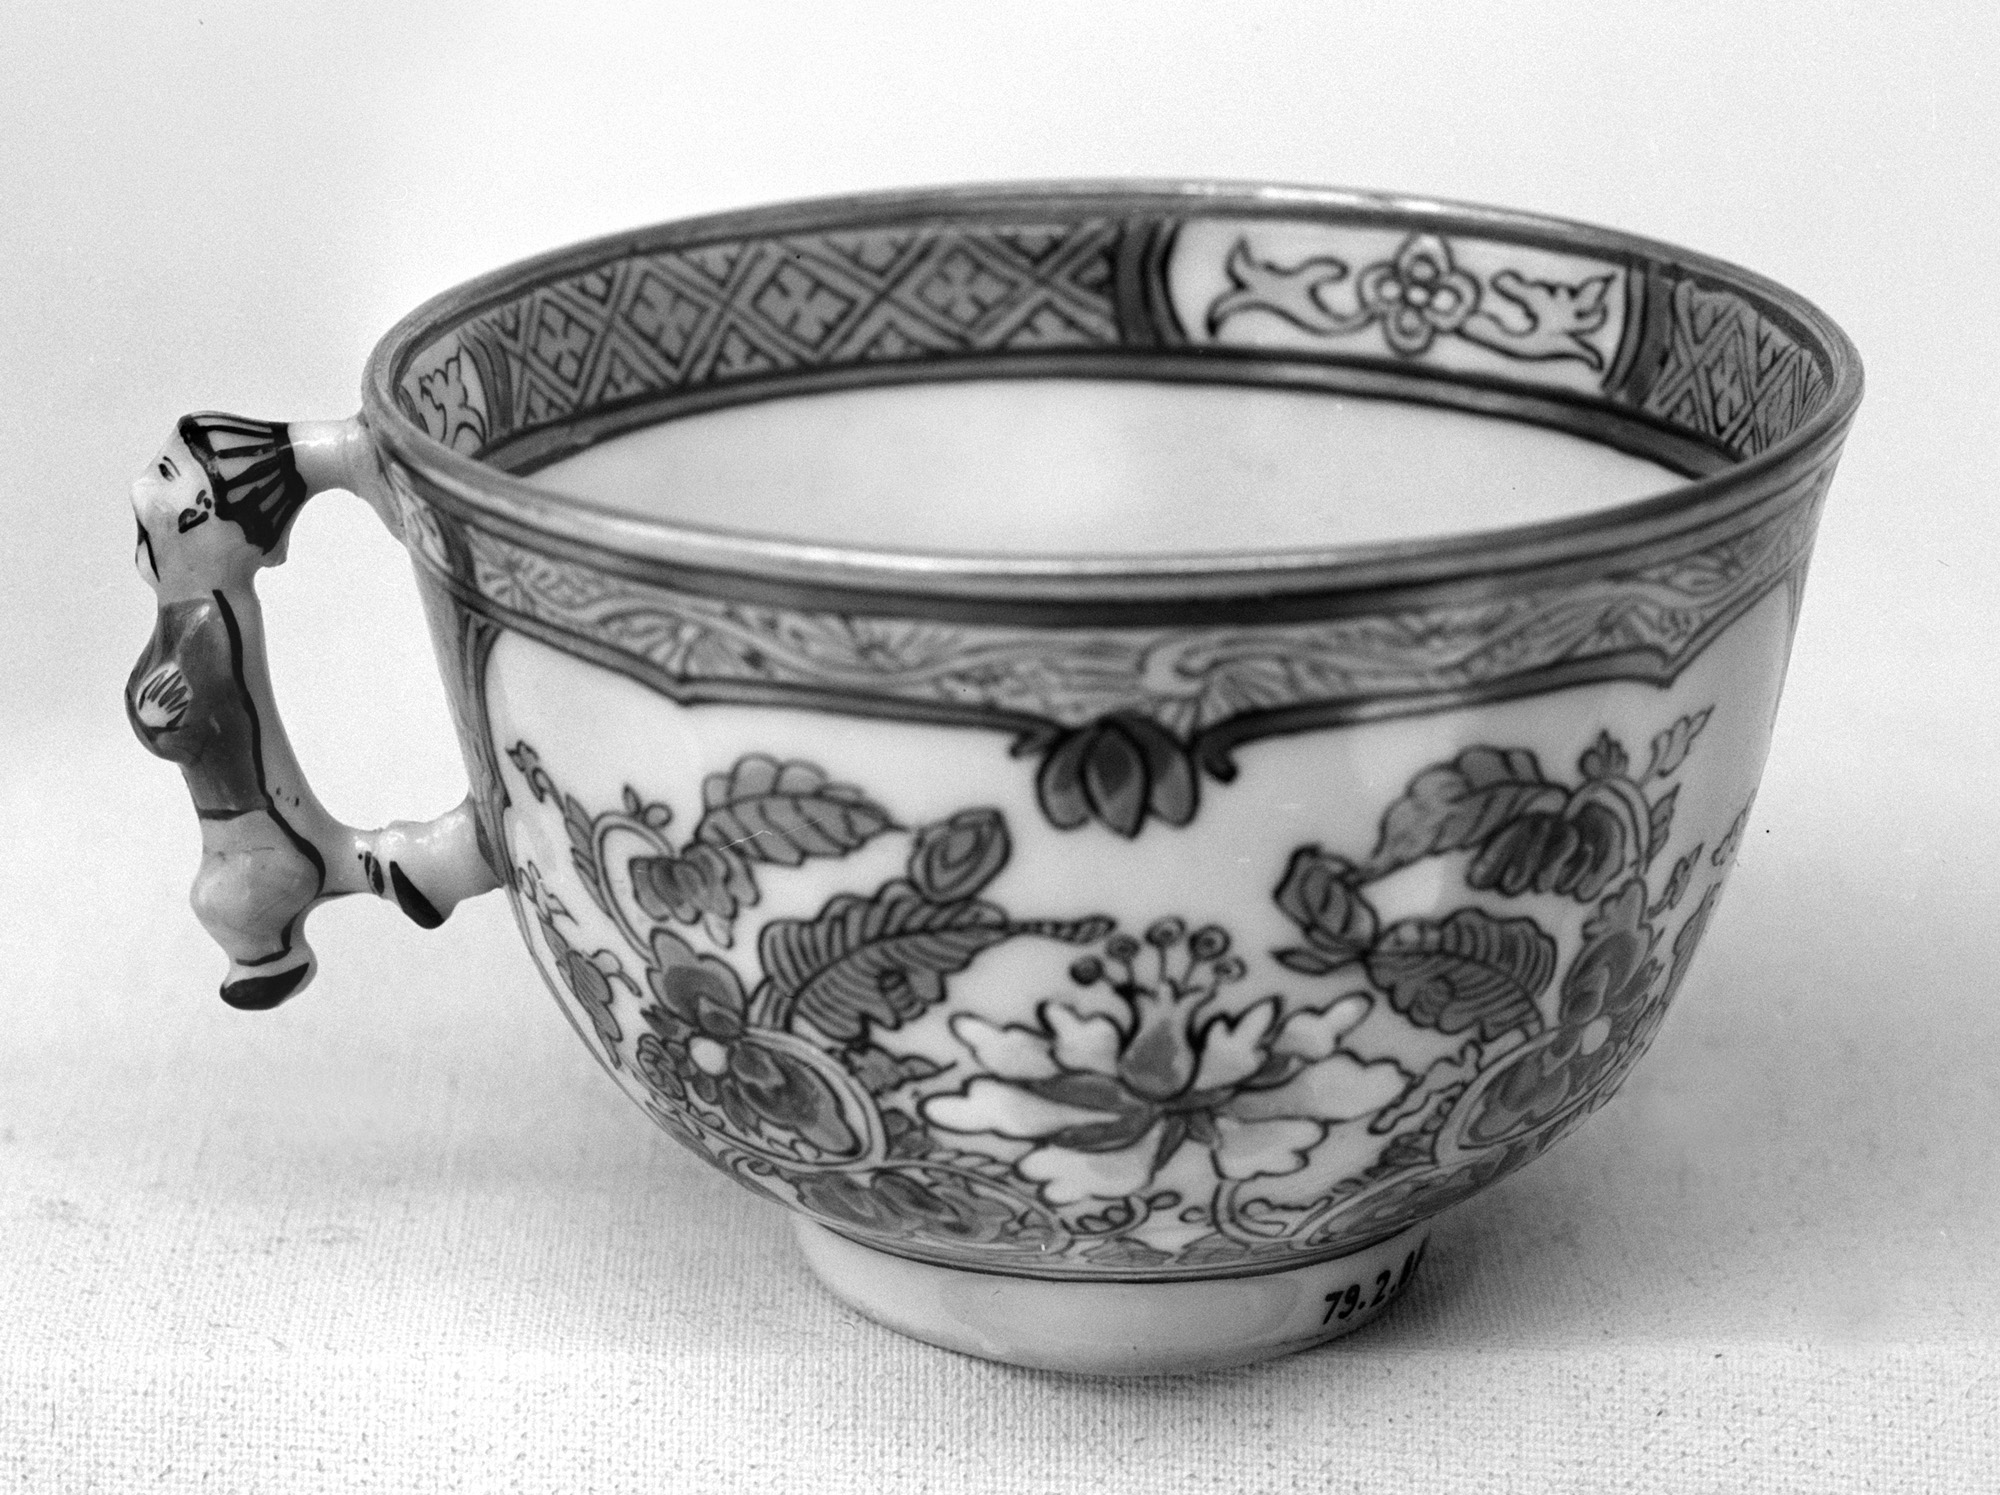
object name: shard of a cup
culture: chinese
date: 1801-1900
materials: enamel, porcelain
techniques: overglaze, painting, polychrome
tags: flowers